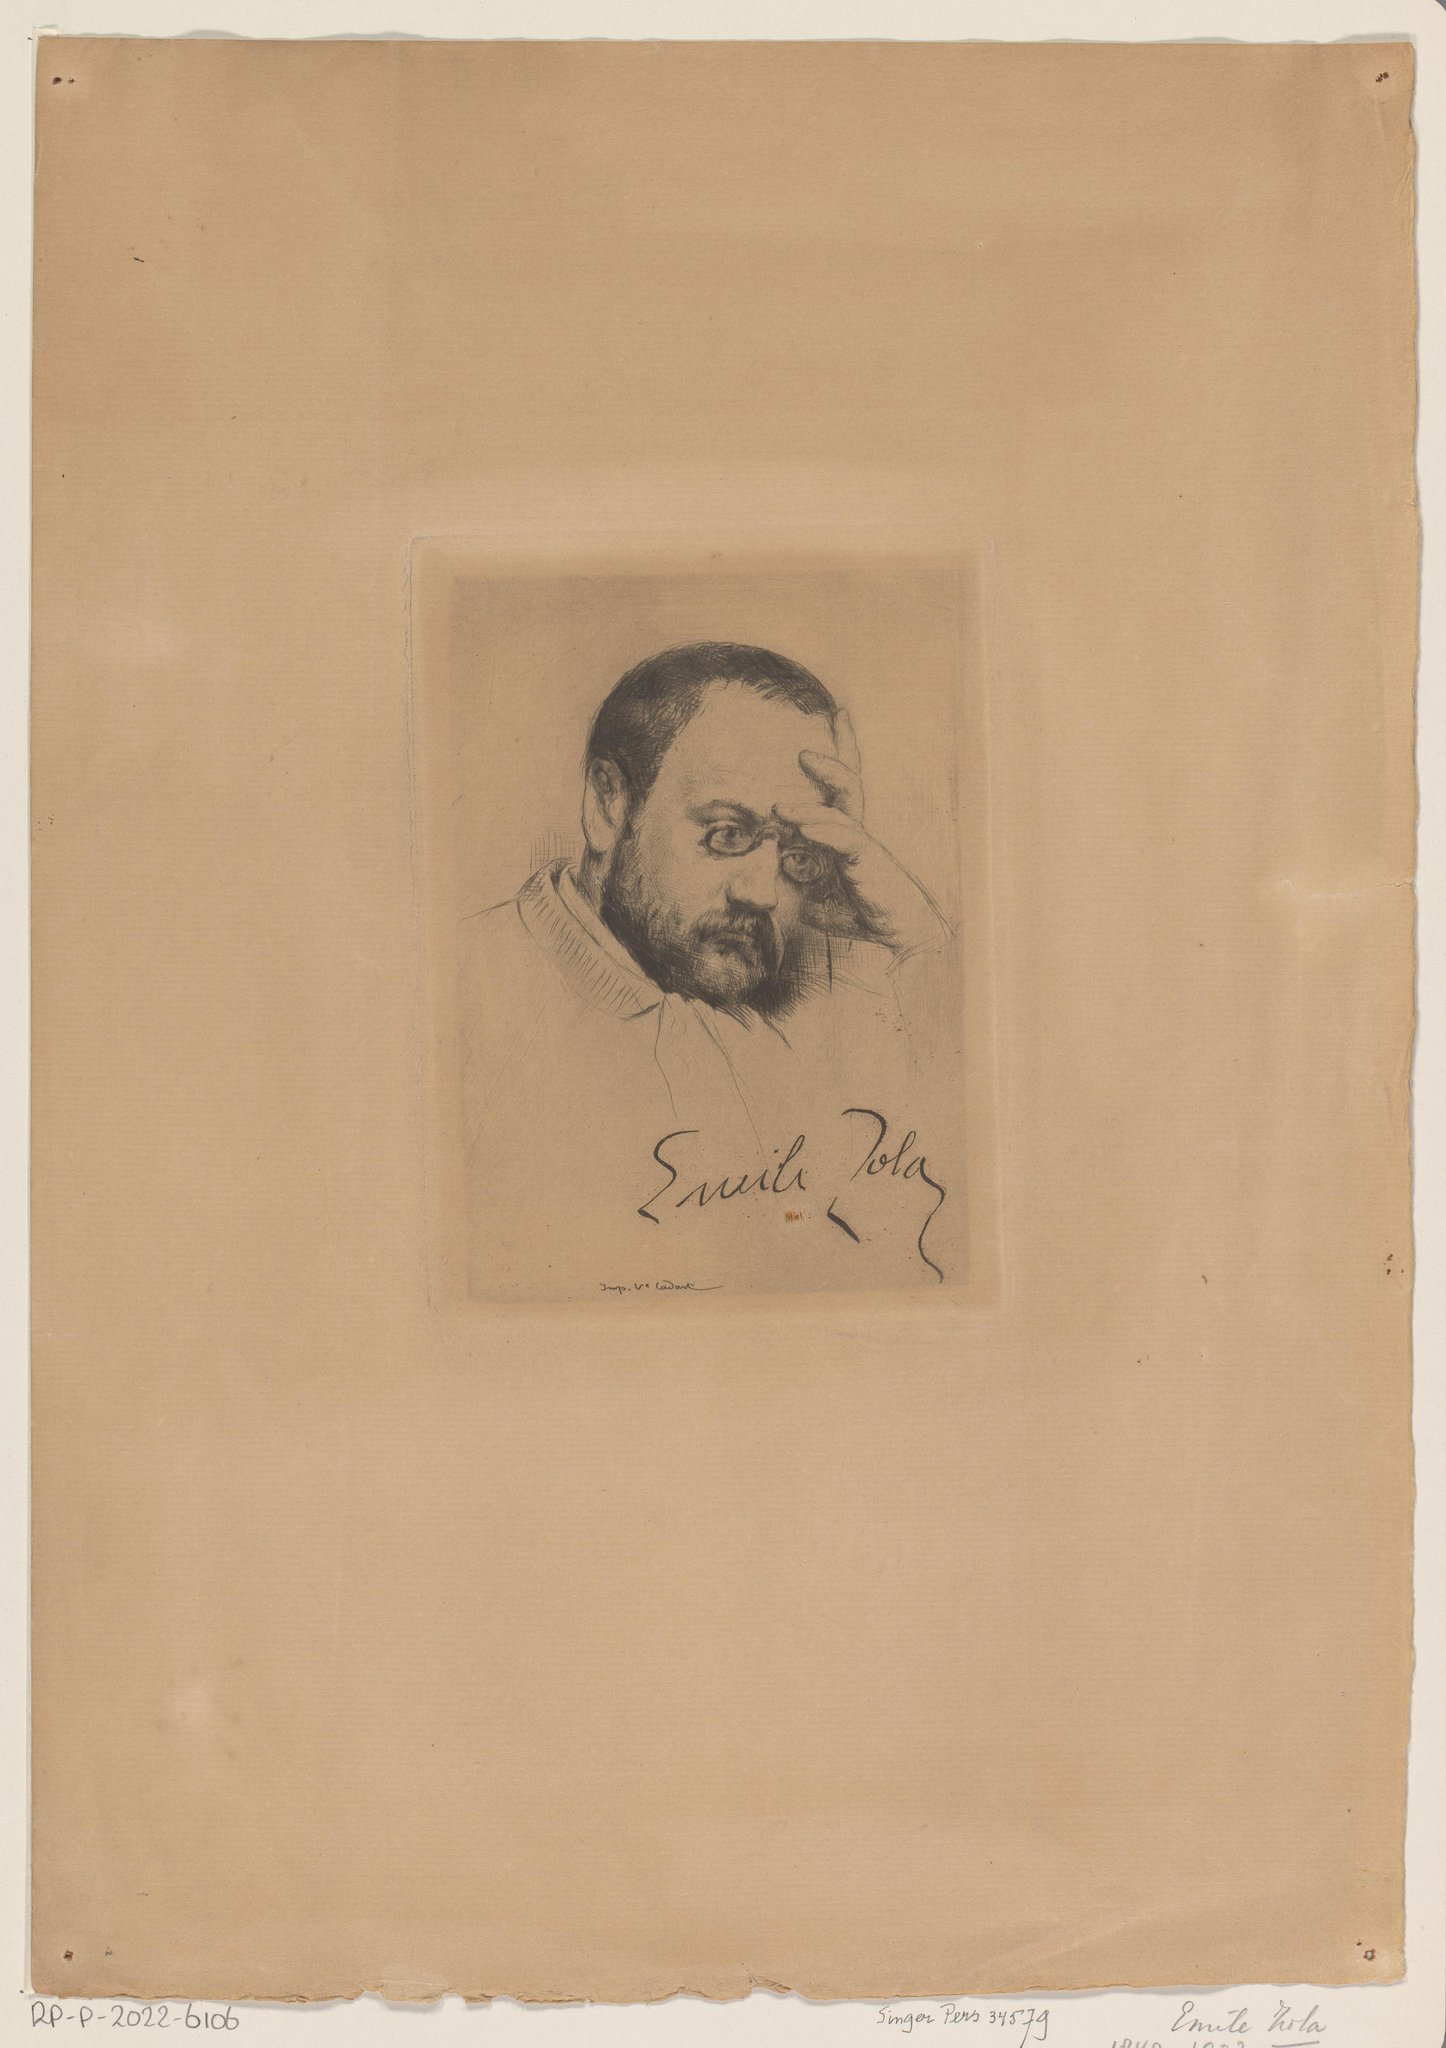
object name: print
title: Portret van Emile Zola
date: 1875-1882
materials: paper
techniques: drypoint, etching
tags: paris, emile zola, historical persons, portrait of a writer